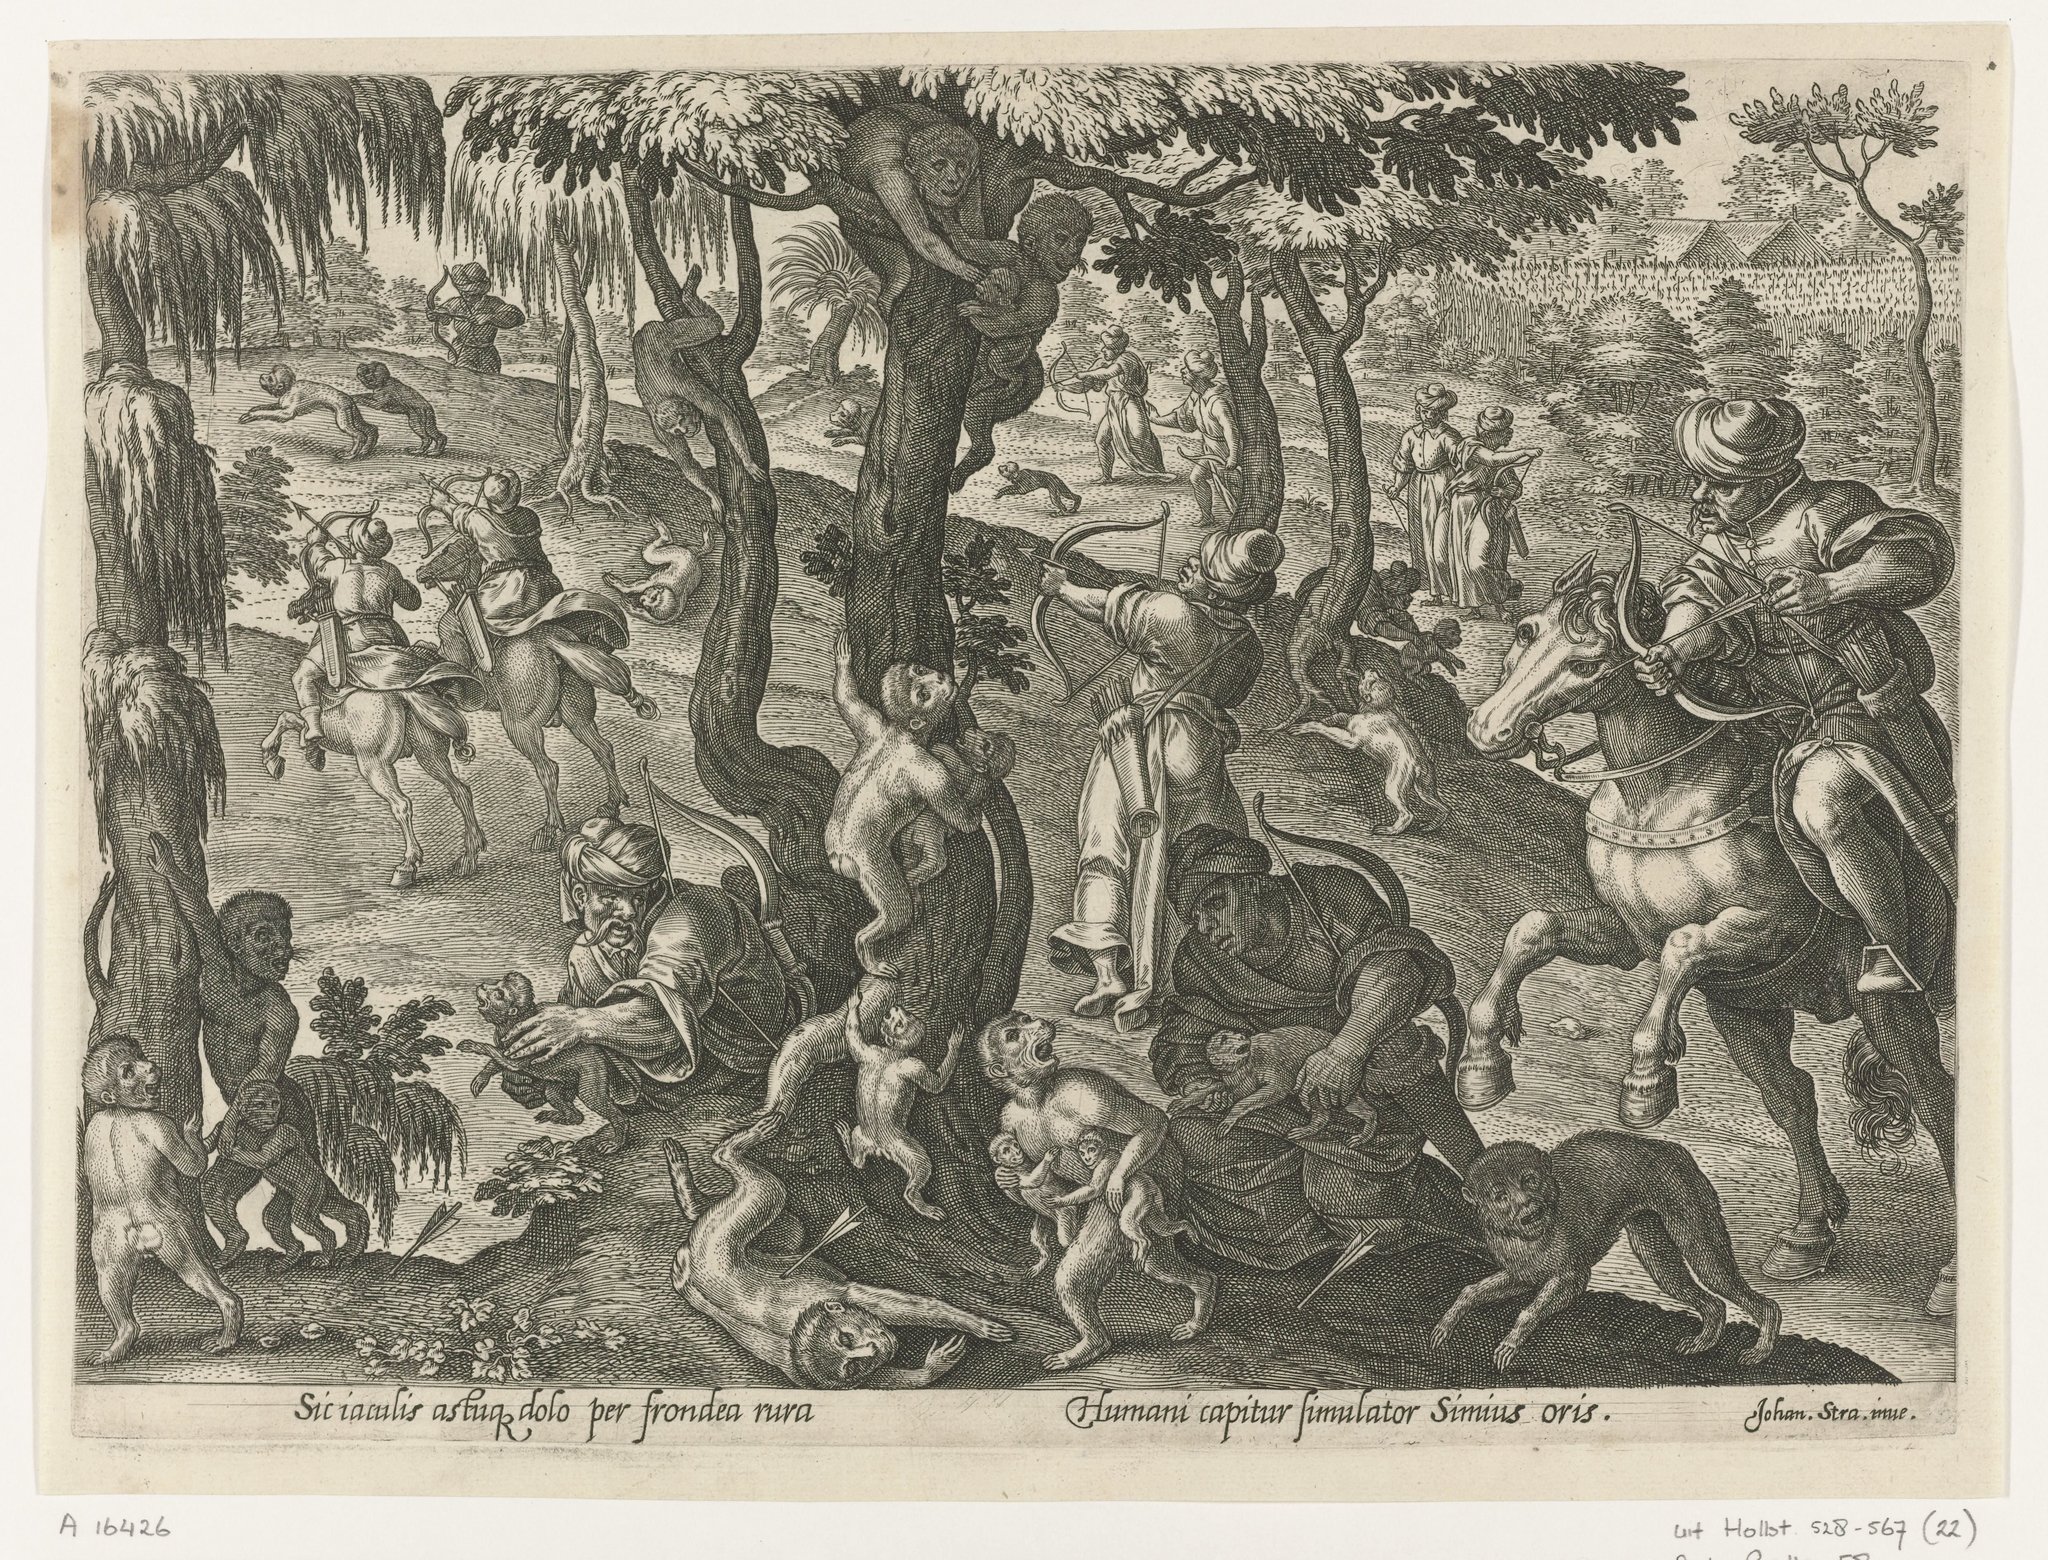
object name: print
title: Jachttaferelen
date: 1578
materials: paper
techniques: engraving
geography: florence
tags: monkeys, apes, hunt ~ other mammals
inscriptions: collector's mark: Lugt 2228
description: Ruiters en jagers te voeten schieten met pijl en boog op apen in de bomen. Op de voorgrond een apenmoeder met twee jongen. Met 2 regels onderschrift in Latijn. No. 22 uit serie van 43 jachten.